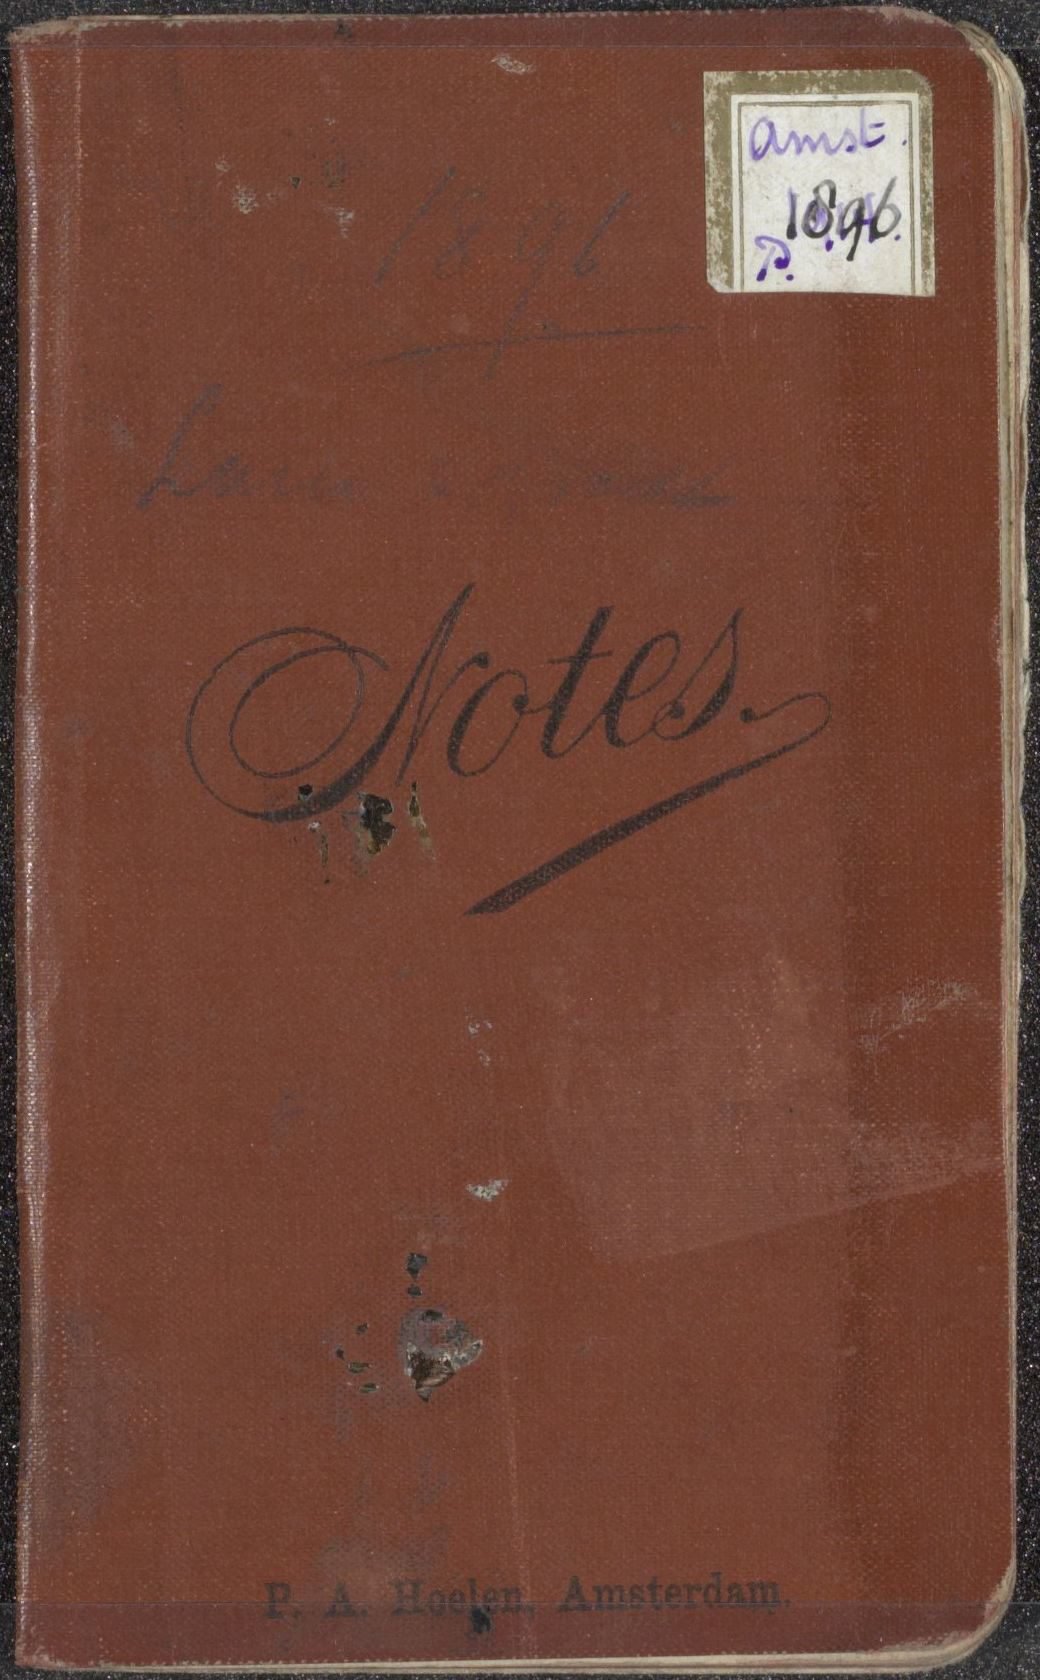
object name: sketchbook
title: Schetsboek met 20 bladen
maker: george hendrik breitner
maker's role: draughtsman, painter, print maker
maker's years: 1857-1923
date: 1896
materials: cardboard, chalk, linen, pencil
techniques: printing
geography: scheveningen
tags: sitting figure - aa - female human figure, street, amsterdam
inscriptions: workshop stamp: Lugt 291d, annotation: ‘Amst./ 1896./ P./ 1896/ Laur ergracht’, retailer's mark: ‘P.A. Hoelen, Amsterdam.’, collector's mark: Lugt 2228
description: Het schetsboek is foutief gepagineerd, waardoor de paginanummers 2 en 3 niet bestaan.